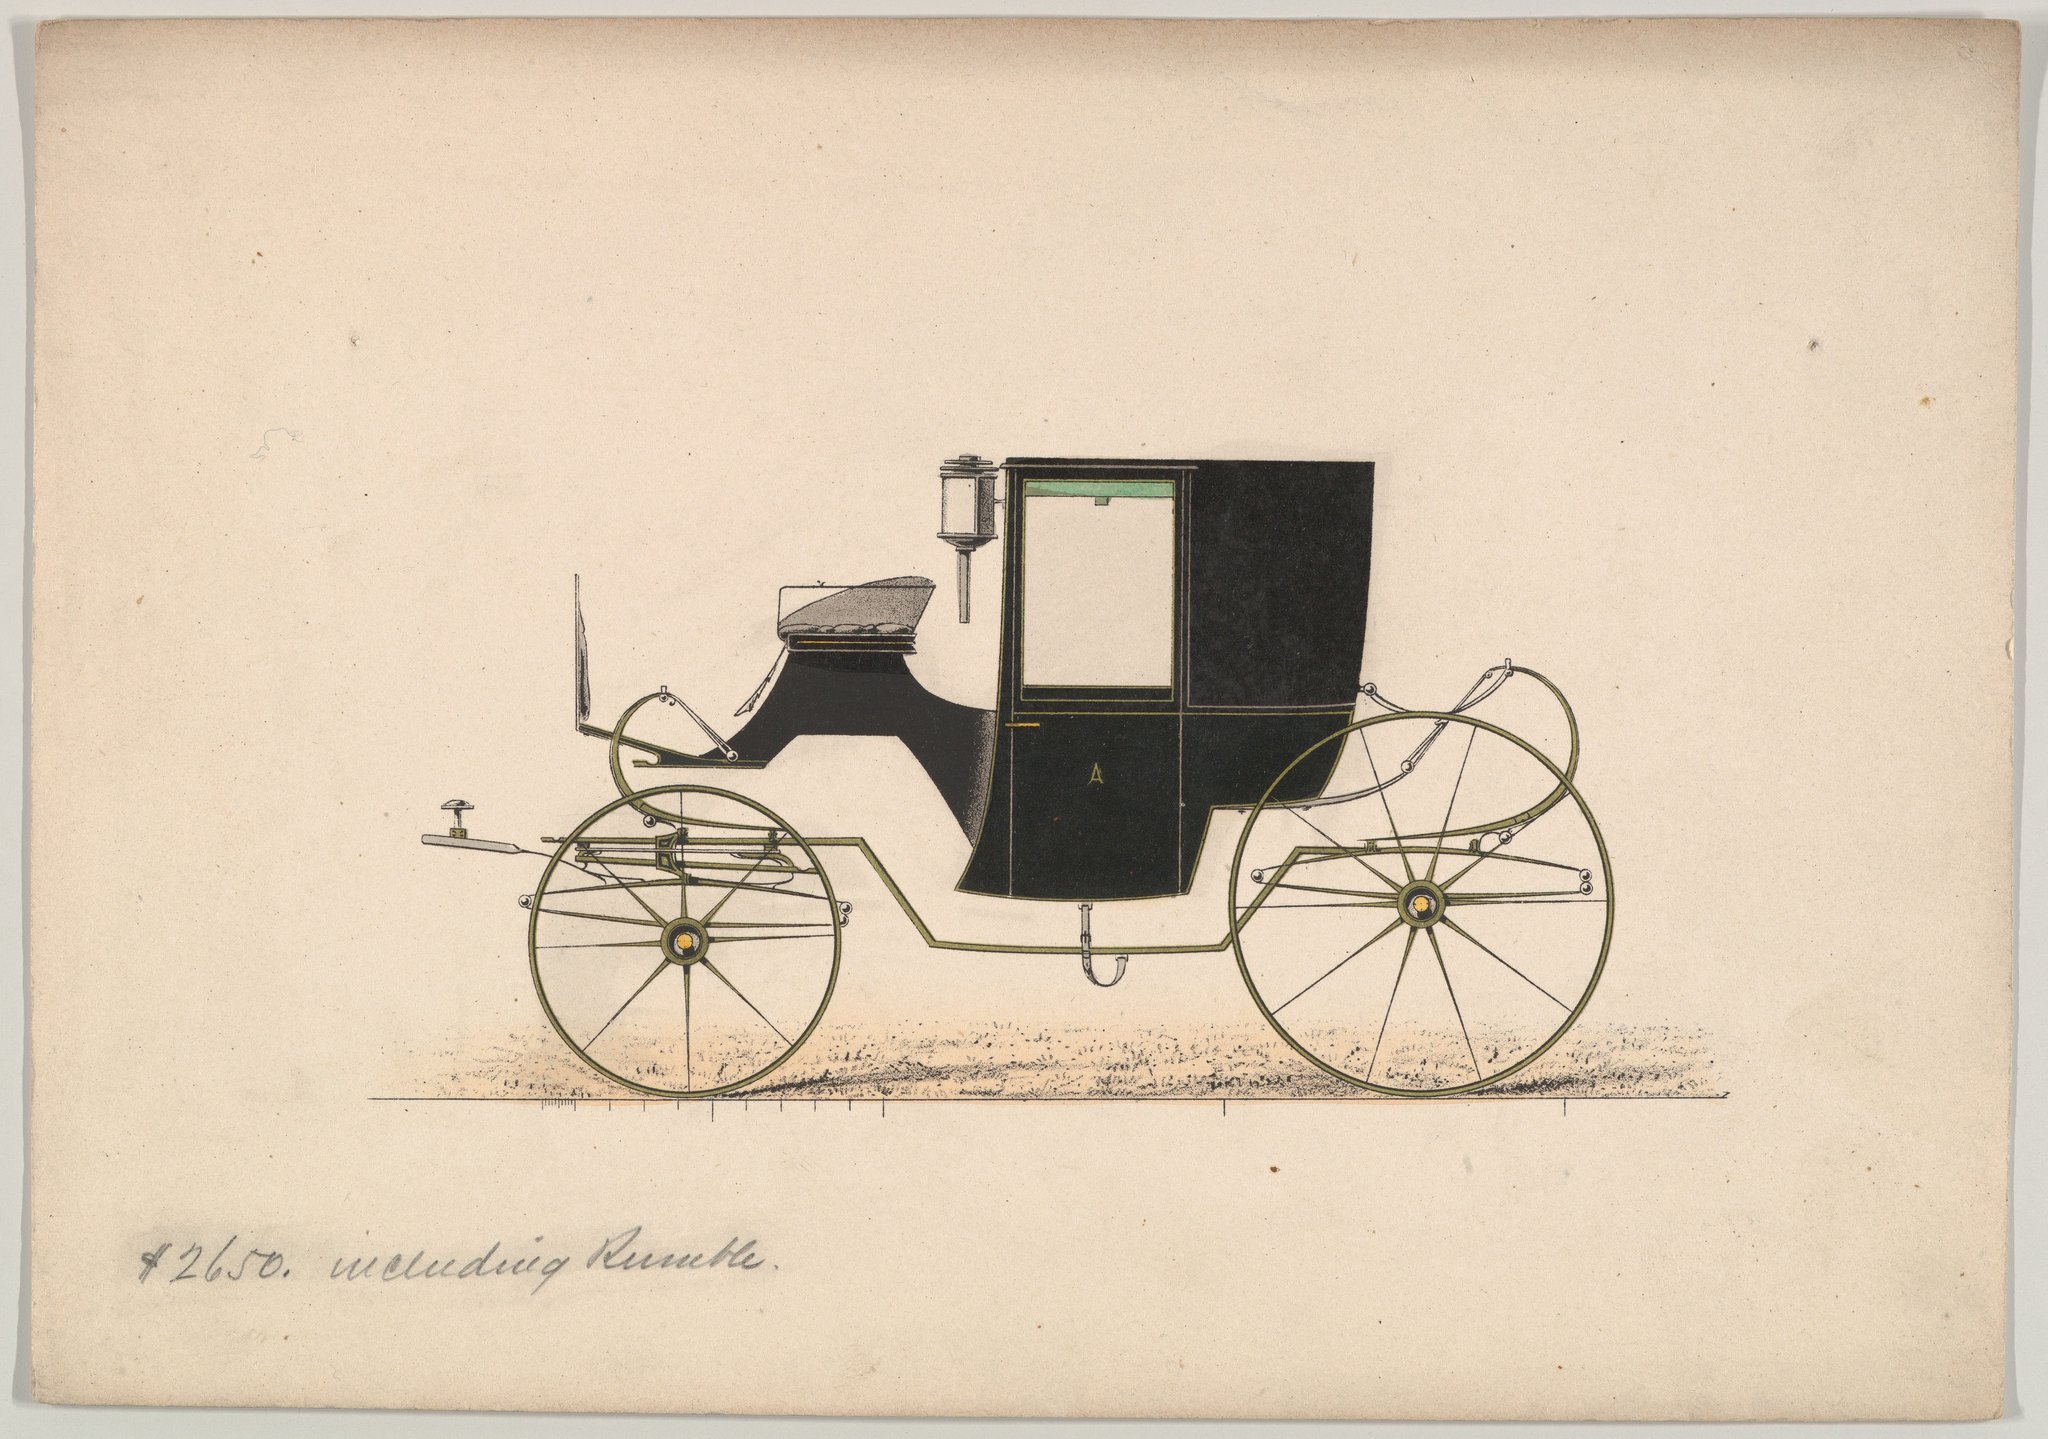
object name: drawing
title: Brougham (unnumbered)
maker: brewster & co.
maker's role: manufacturer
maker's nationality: american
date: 1850-1870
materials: gouache, graphite, ink, watercolor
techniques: pen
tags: carriages